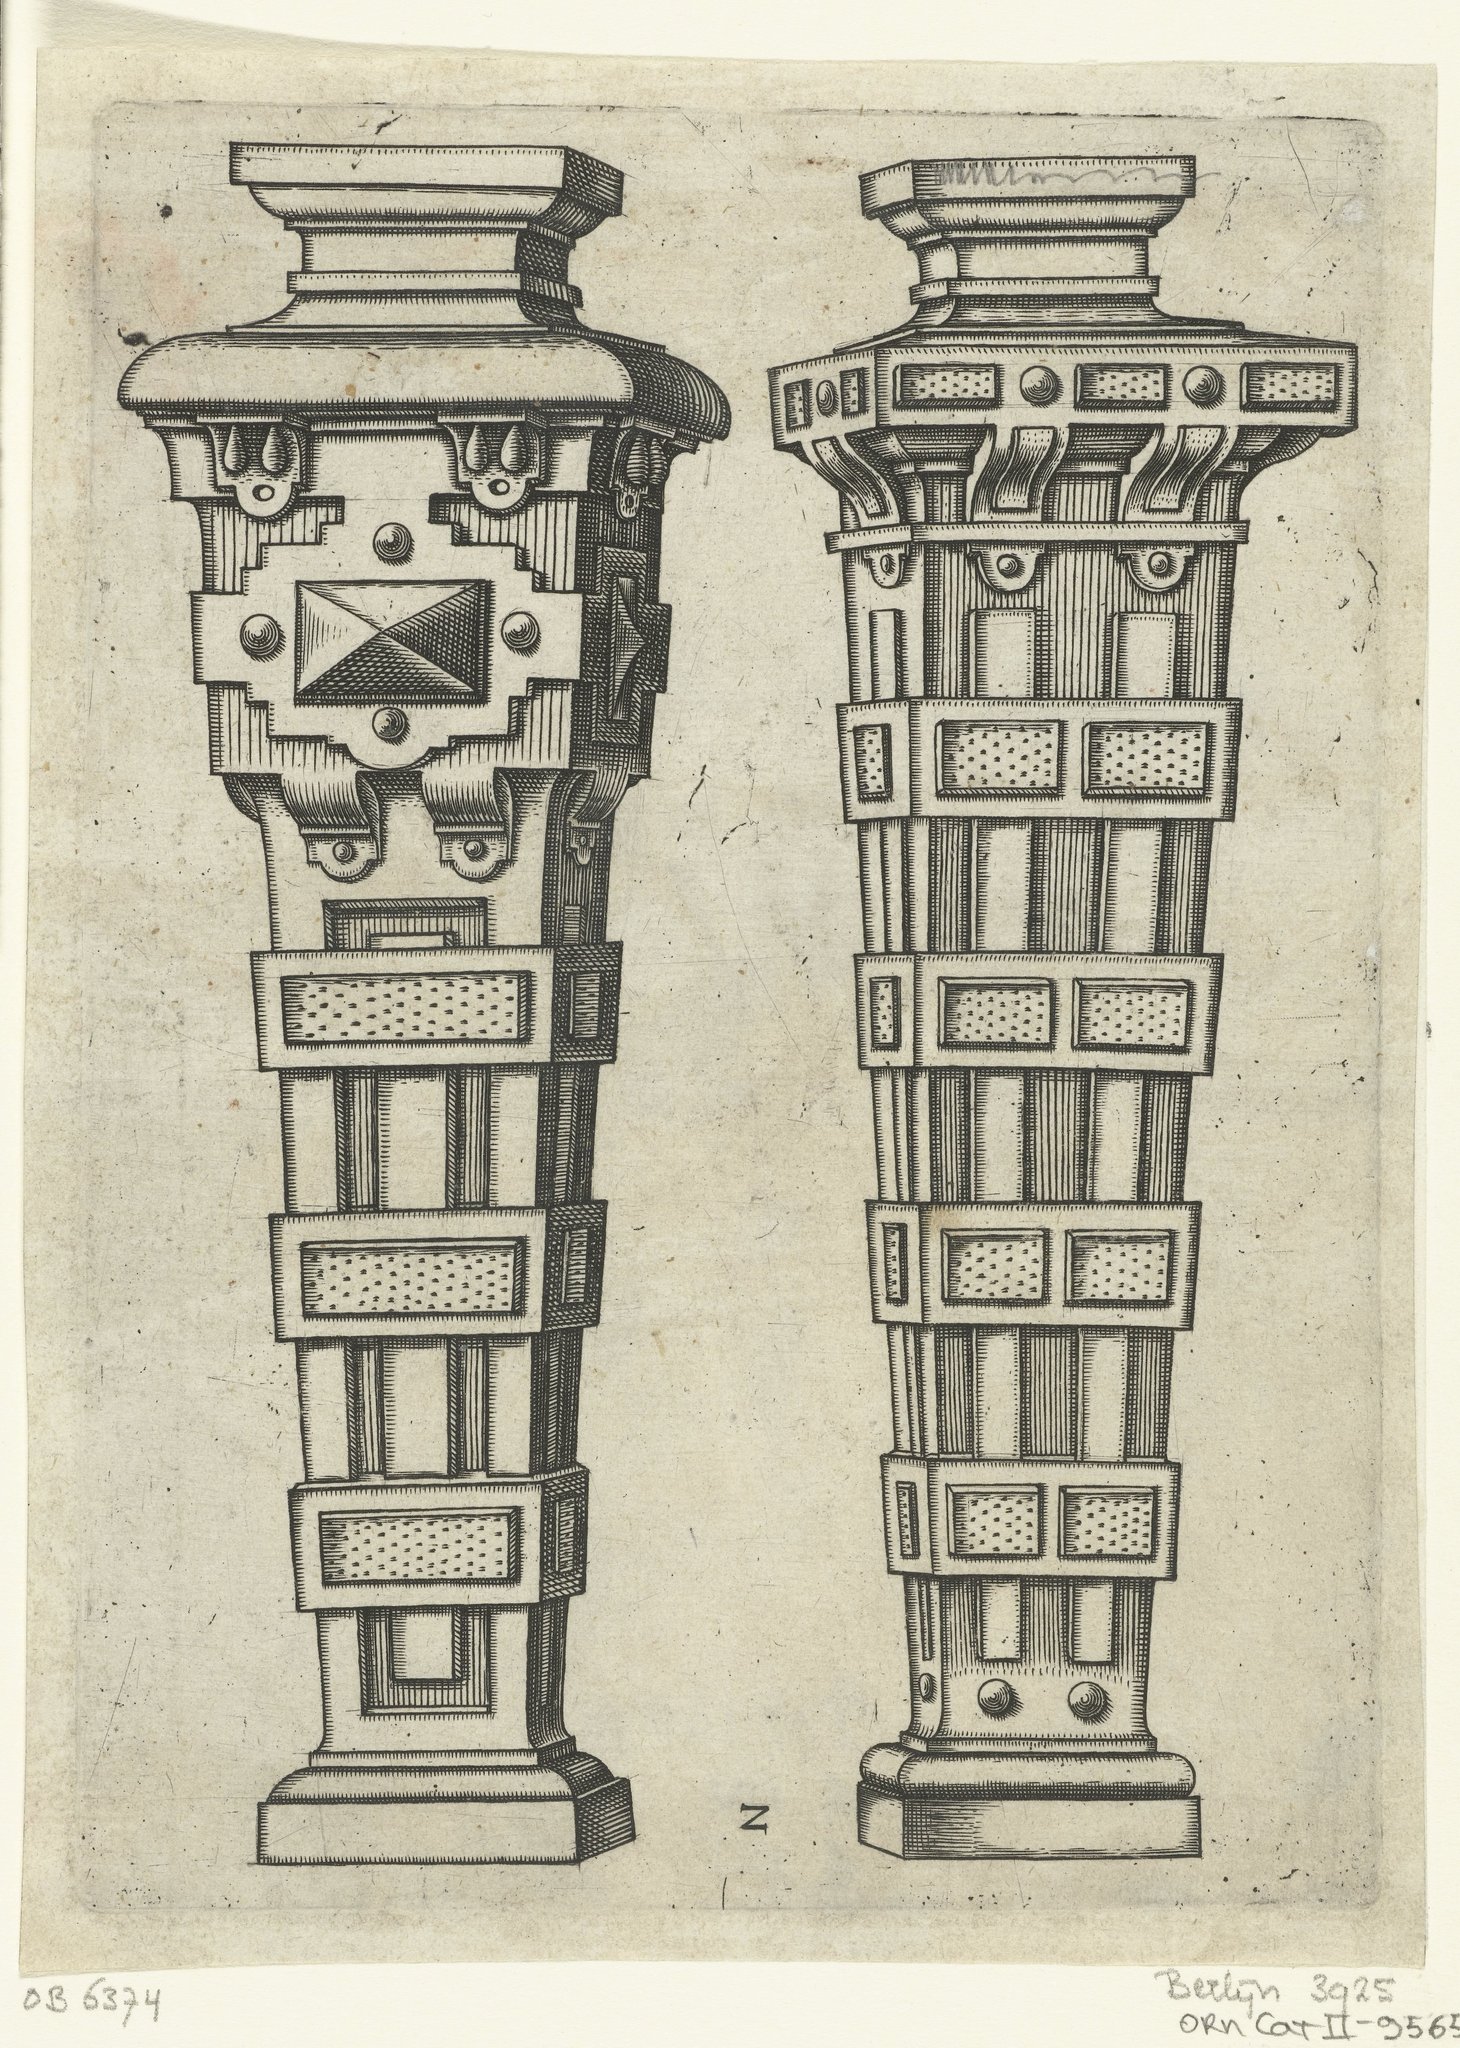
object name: ornament print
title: Twee Toscaanse termen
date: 1604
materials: paper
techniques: engraving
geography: amsterdam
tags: tuscan order ~ architecture